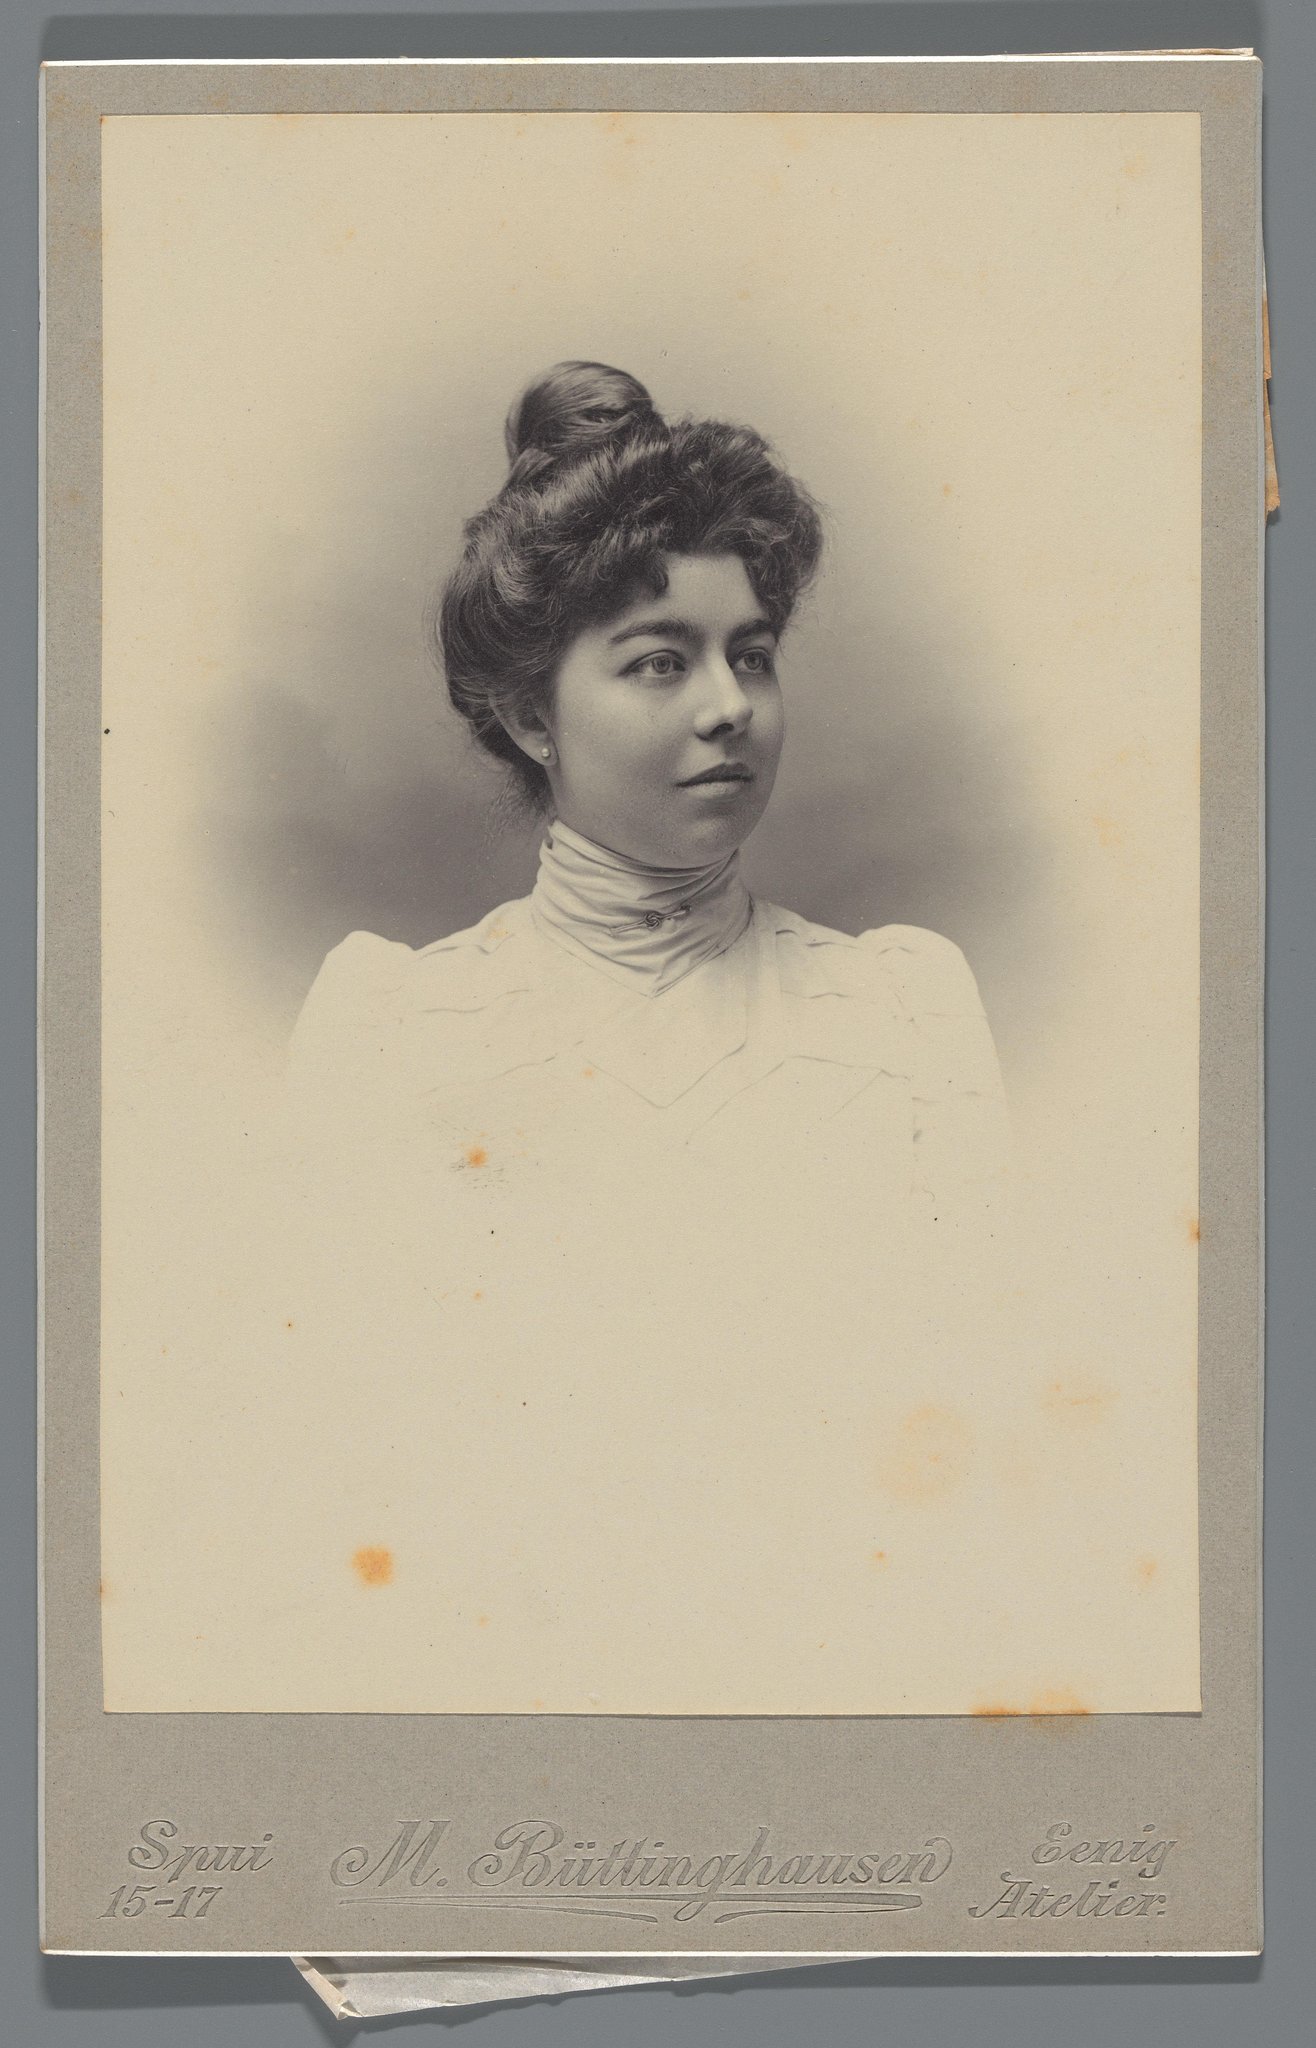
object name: cabinet photograph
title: Portret van A.C.M. Geertsema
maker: max büttinghausen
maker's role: fotograaf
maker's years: 1847-1906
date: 1870-1910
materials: cardboard, photographic support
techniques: albumen print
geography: spui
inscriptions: inscription: ‘Spui / 15 - 17 / M. Büttinghausen / Eenig / Atelier.’, name